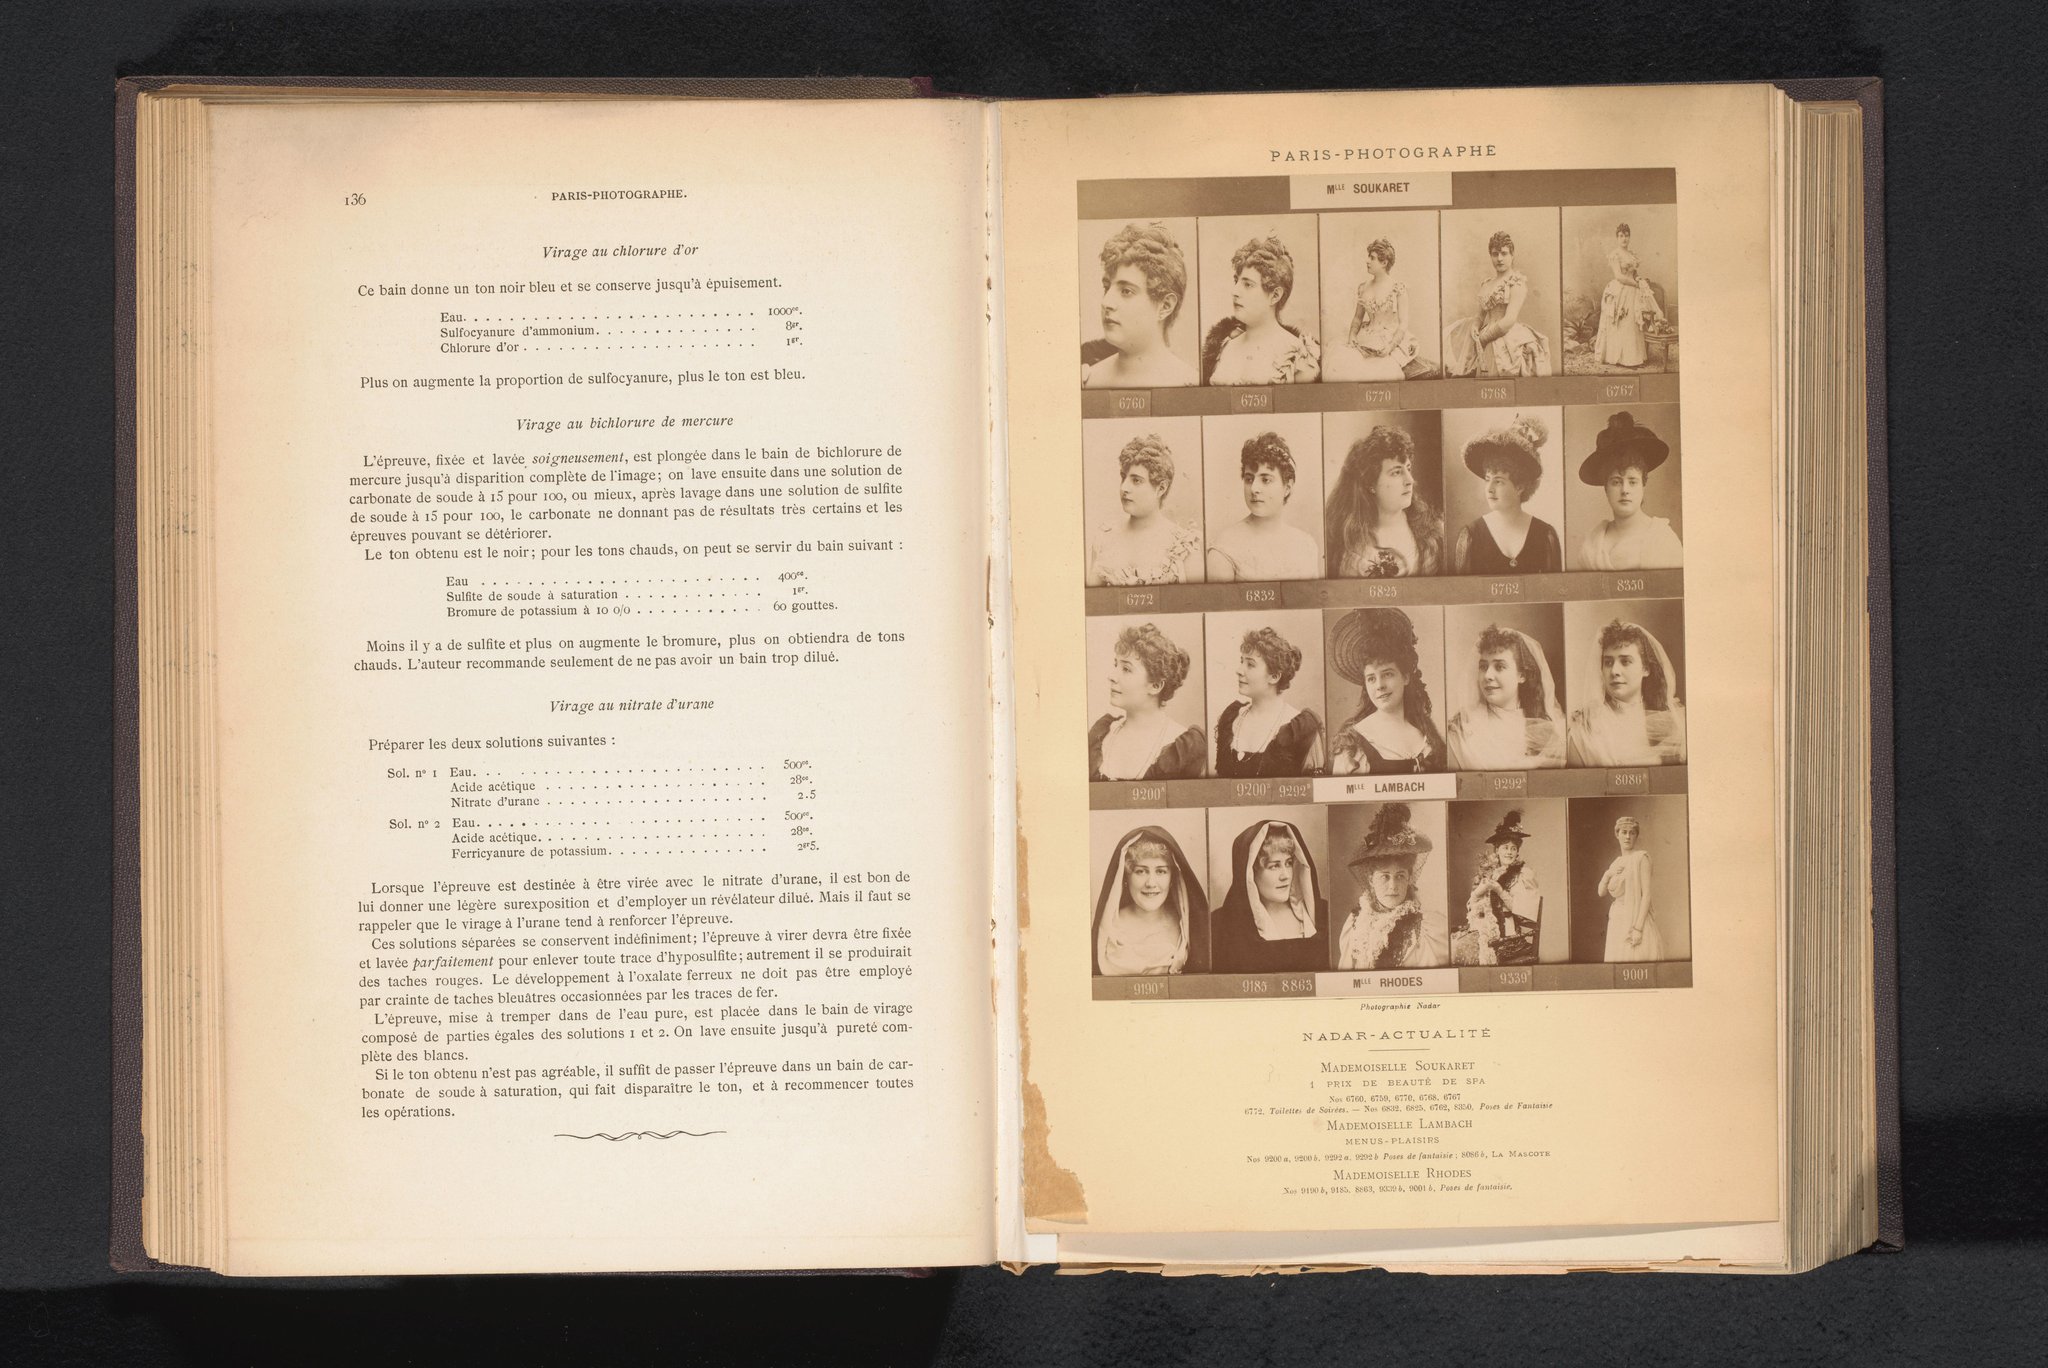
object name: page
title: Twintig portretten van Mademoiselle Soukaret, Mademoiselle Lambach en Mademoiselle Rhodes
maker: félix nadar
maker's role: ballonvaarder, fotograaf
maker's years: 1820-1910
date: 1882-1892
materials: photographic support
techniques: albumen print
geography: paris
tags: female singer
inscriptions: number: ‘6760 (...) 9001’, inscription: ‘Mademoiselle Soukaret (...)Mademoiselle Lambach (...) Mademoiselle Rhodes (...)’